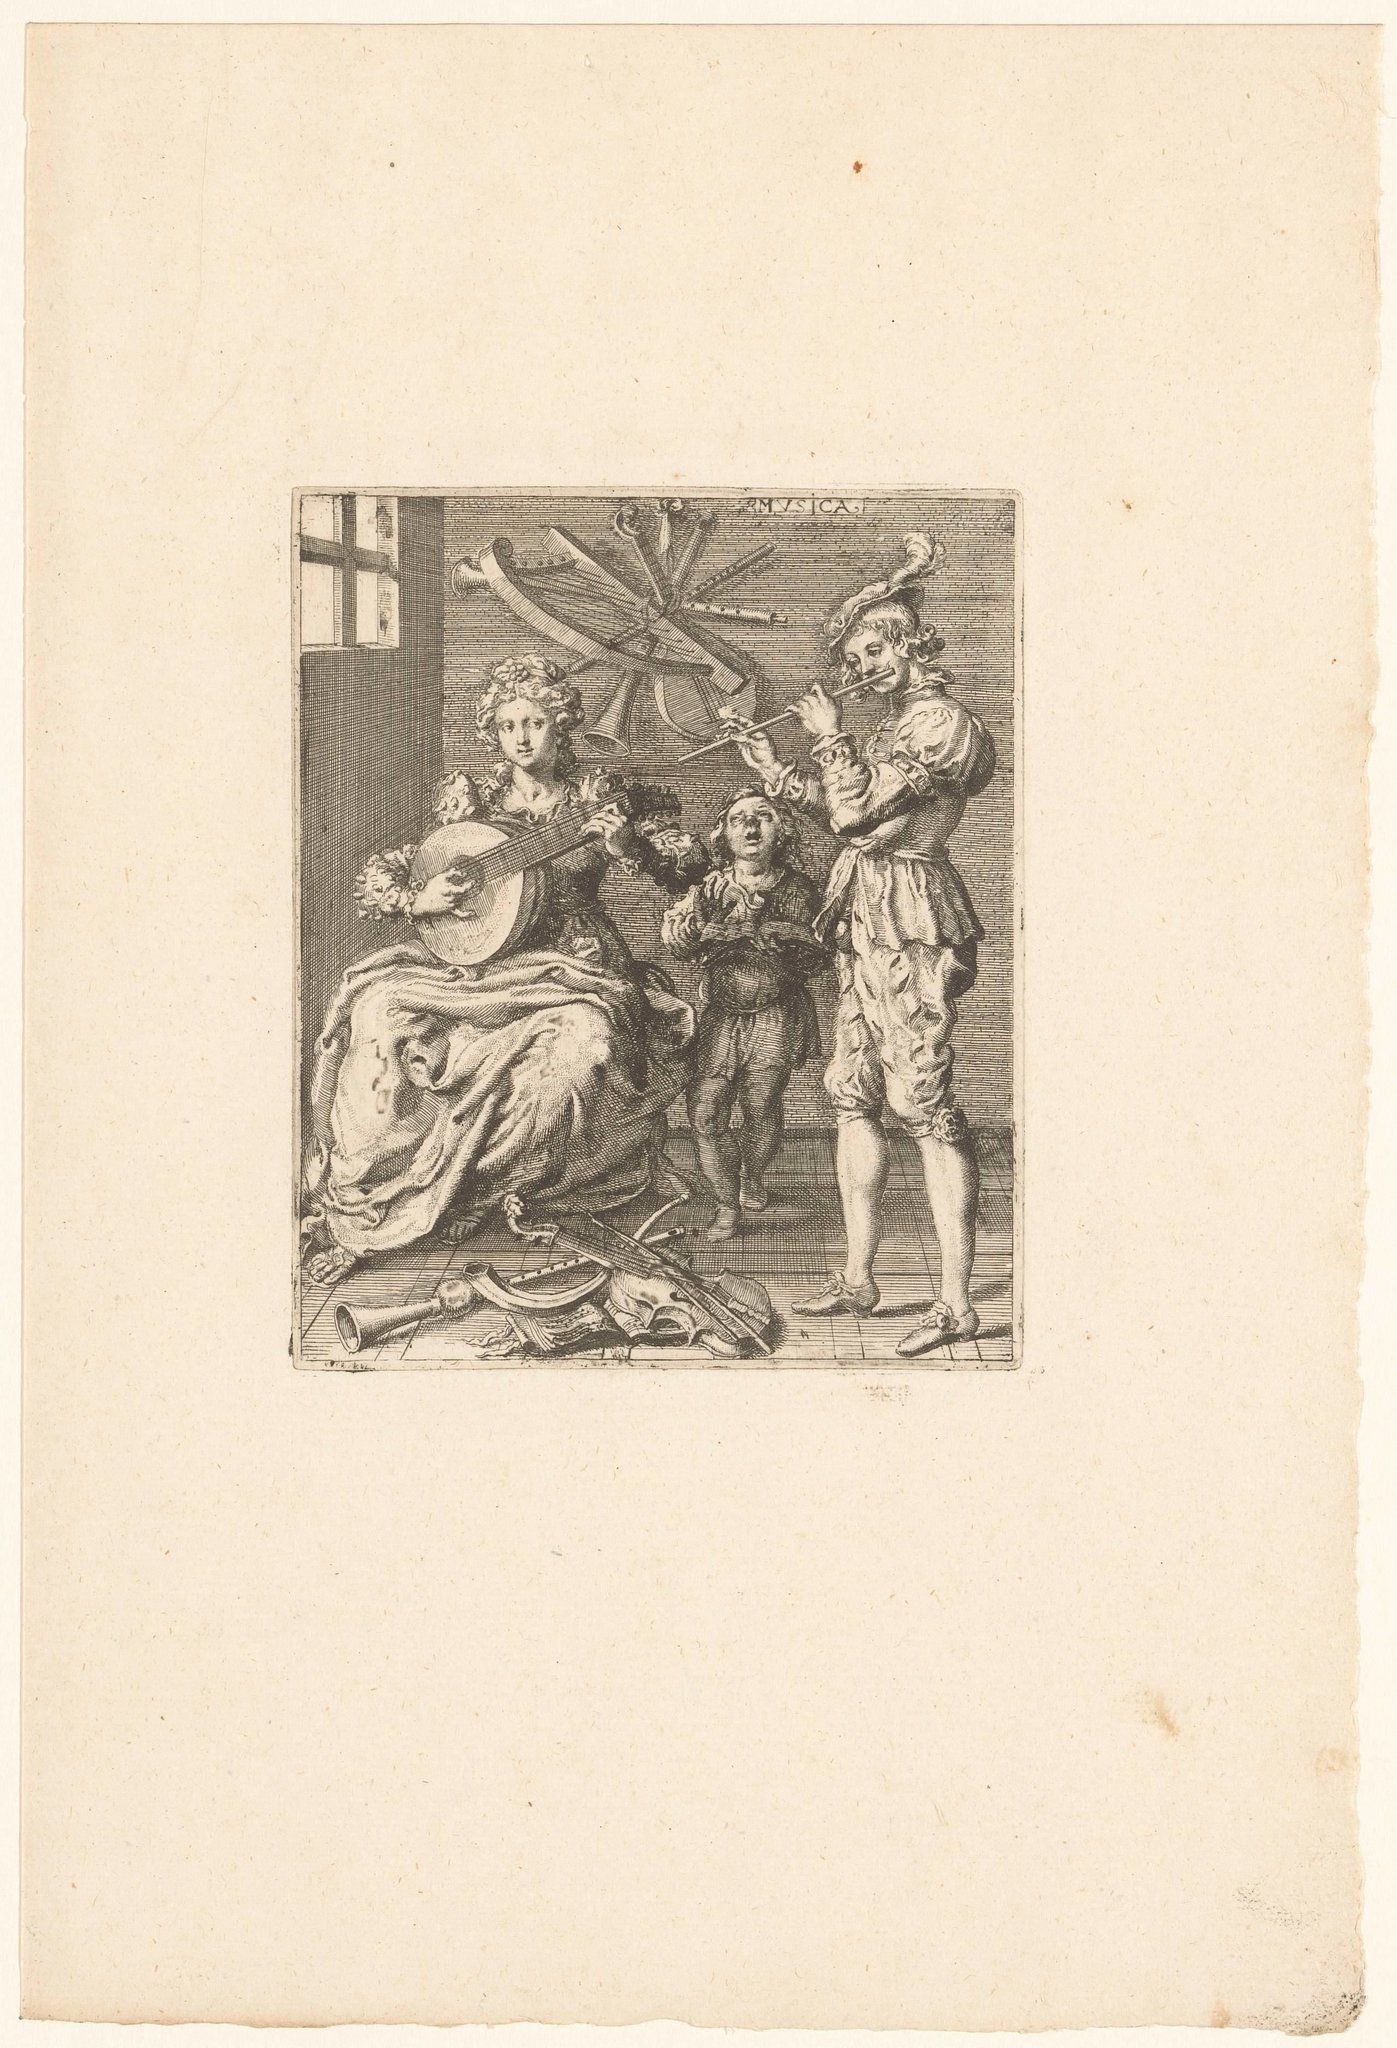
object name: print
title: Septem Liberales Artes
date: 1645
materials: paper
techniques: etching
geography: london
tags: education, science and learning, musical instruments; group of musical instruments, the liberal arts, 'artes liberales', 'musica' (~ quadrivium); 'musica' (ripa), harmonious sound, harmony, consonance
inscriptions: collector's mark: Lugt 2228, collector's mark: Lugt 2760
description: Onderdeel van een serie van zeven prenten en een titelprent.